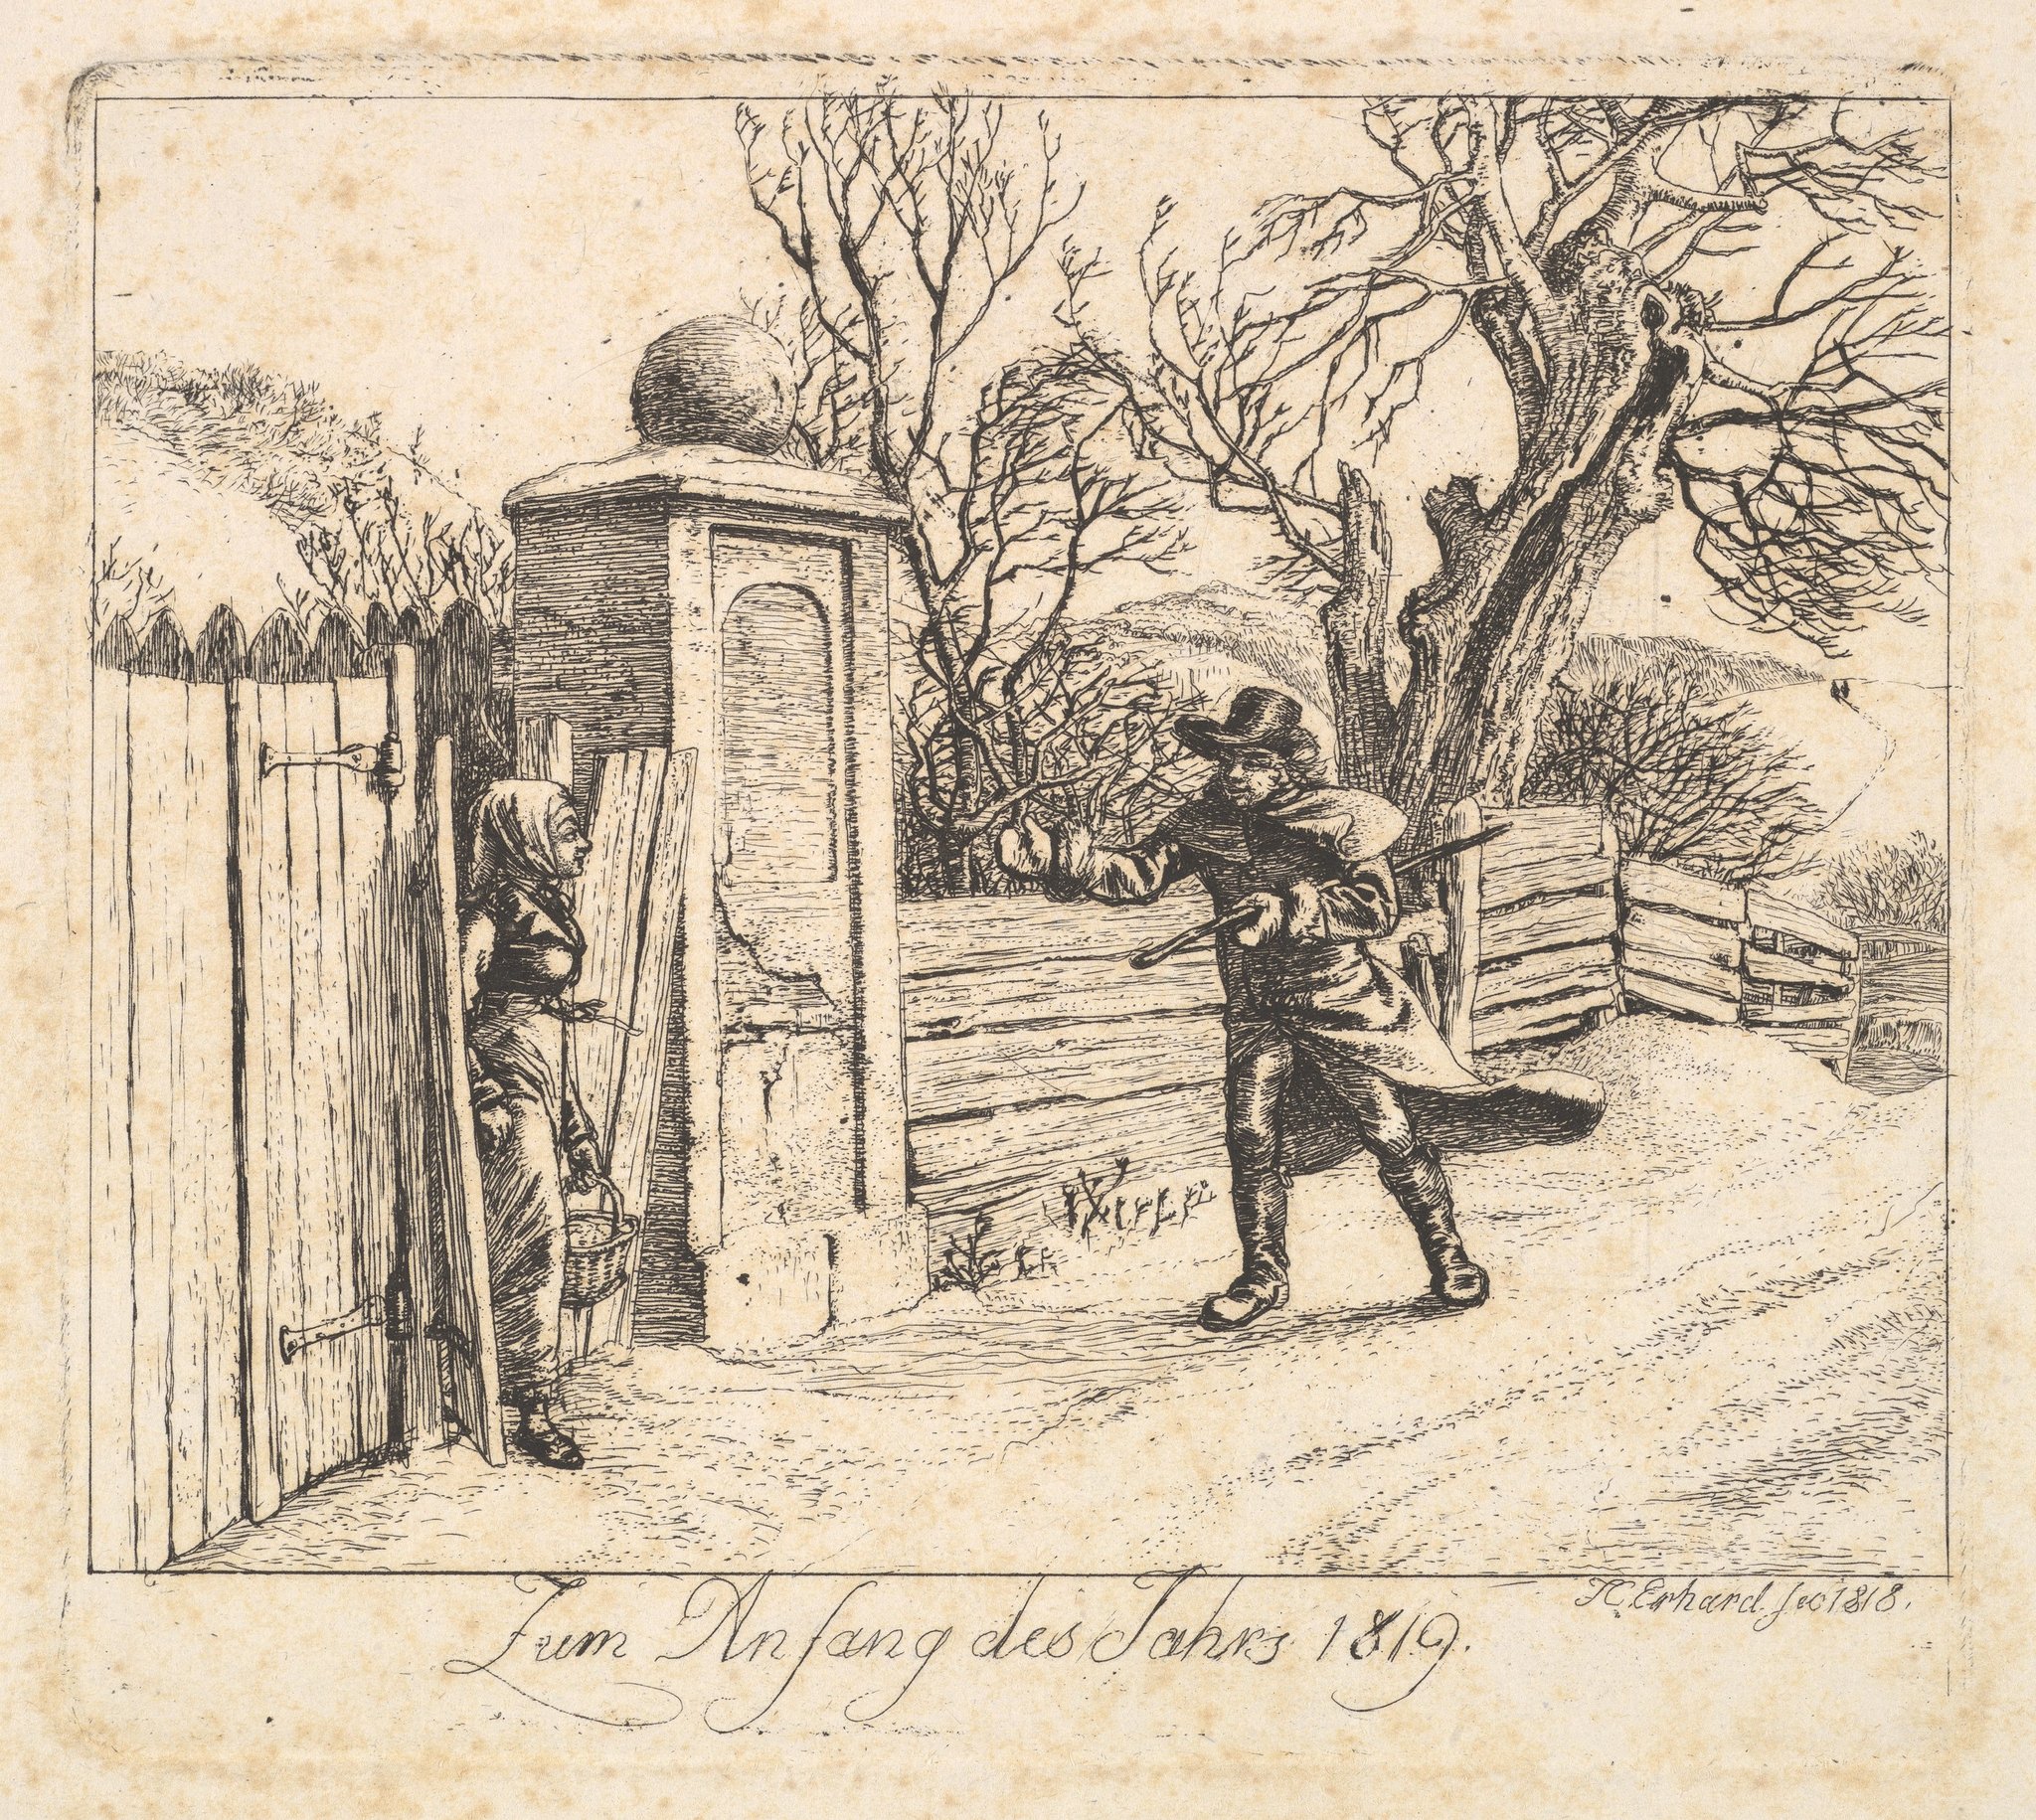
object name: print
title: Winter Landscape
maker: johann christoph erhard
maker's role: artist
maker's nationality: german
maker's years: 1795-1822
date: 1818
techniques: etching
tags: men,women,landscapes,trees,winter